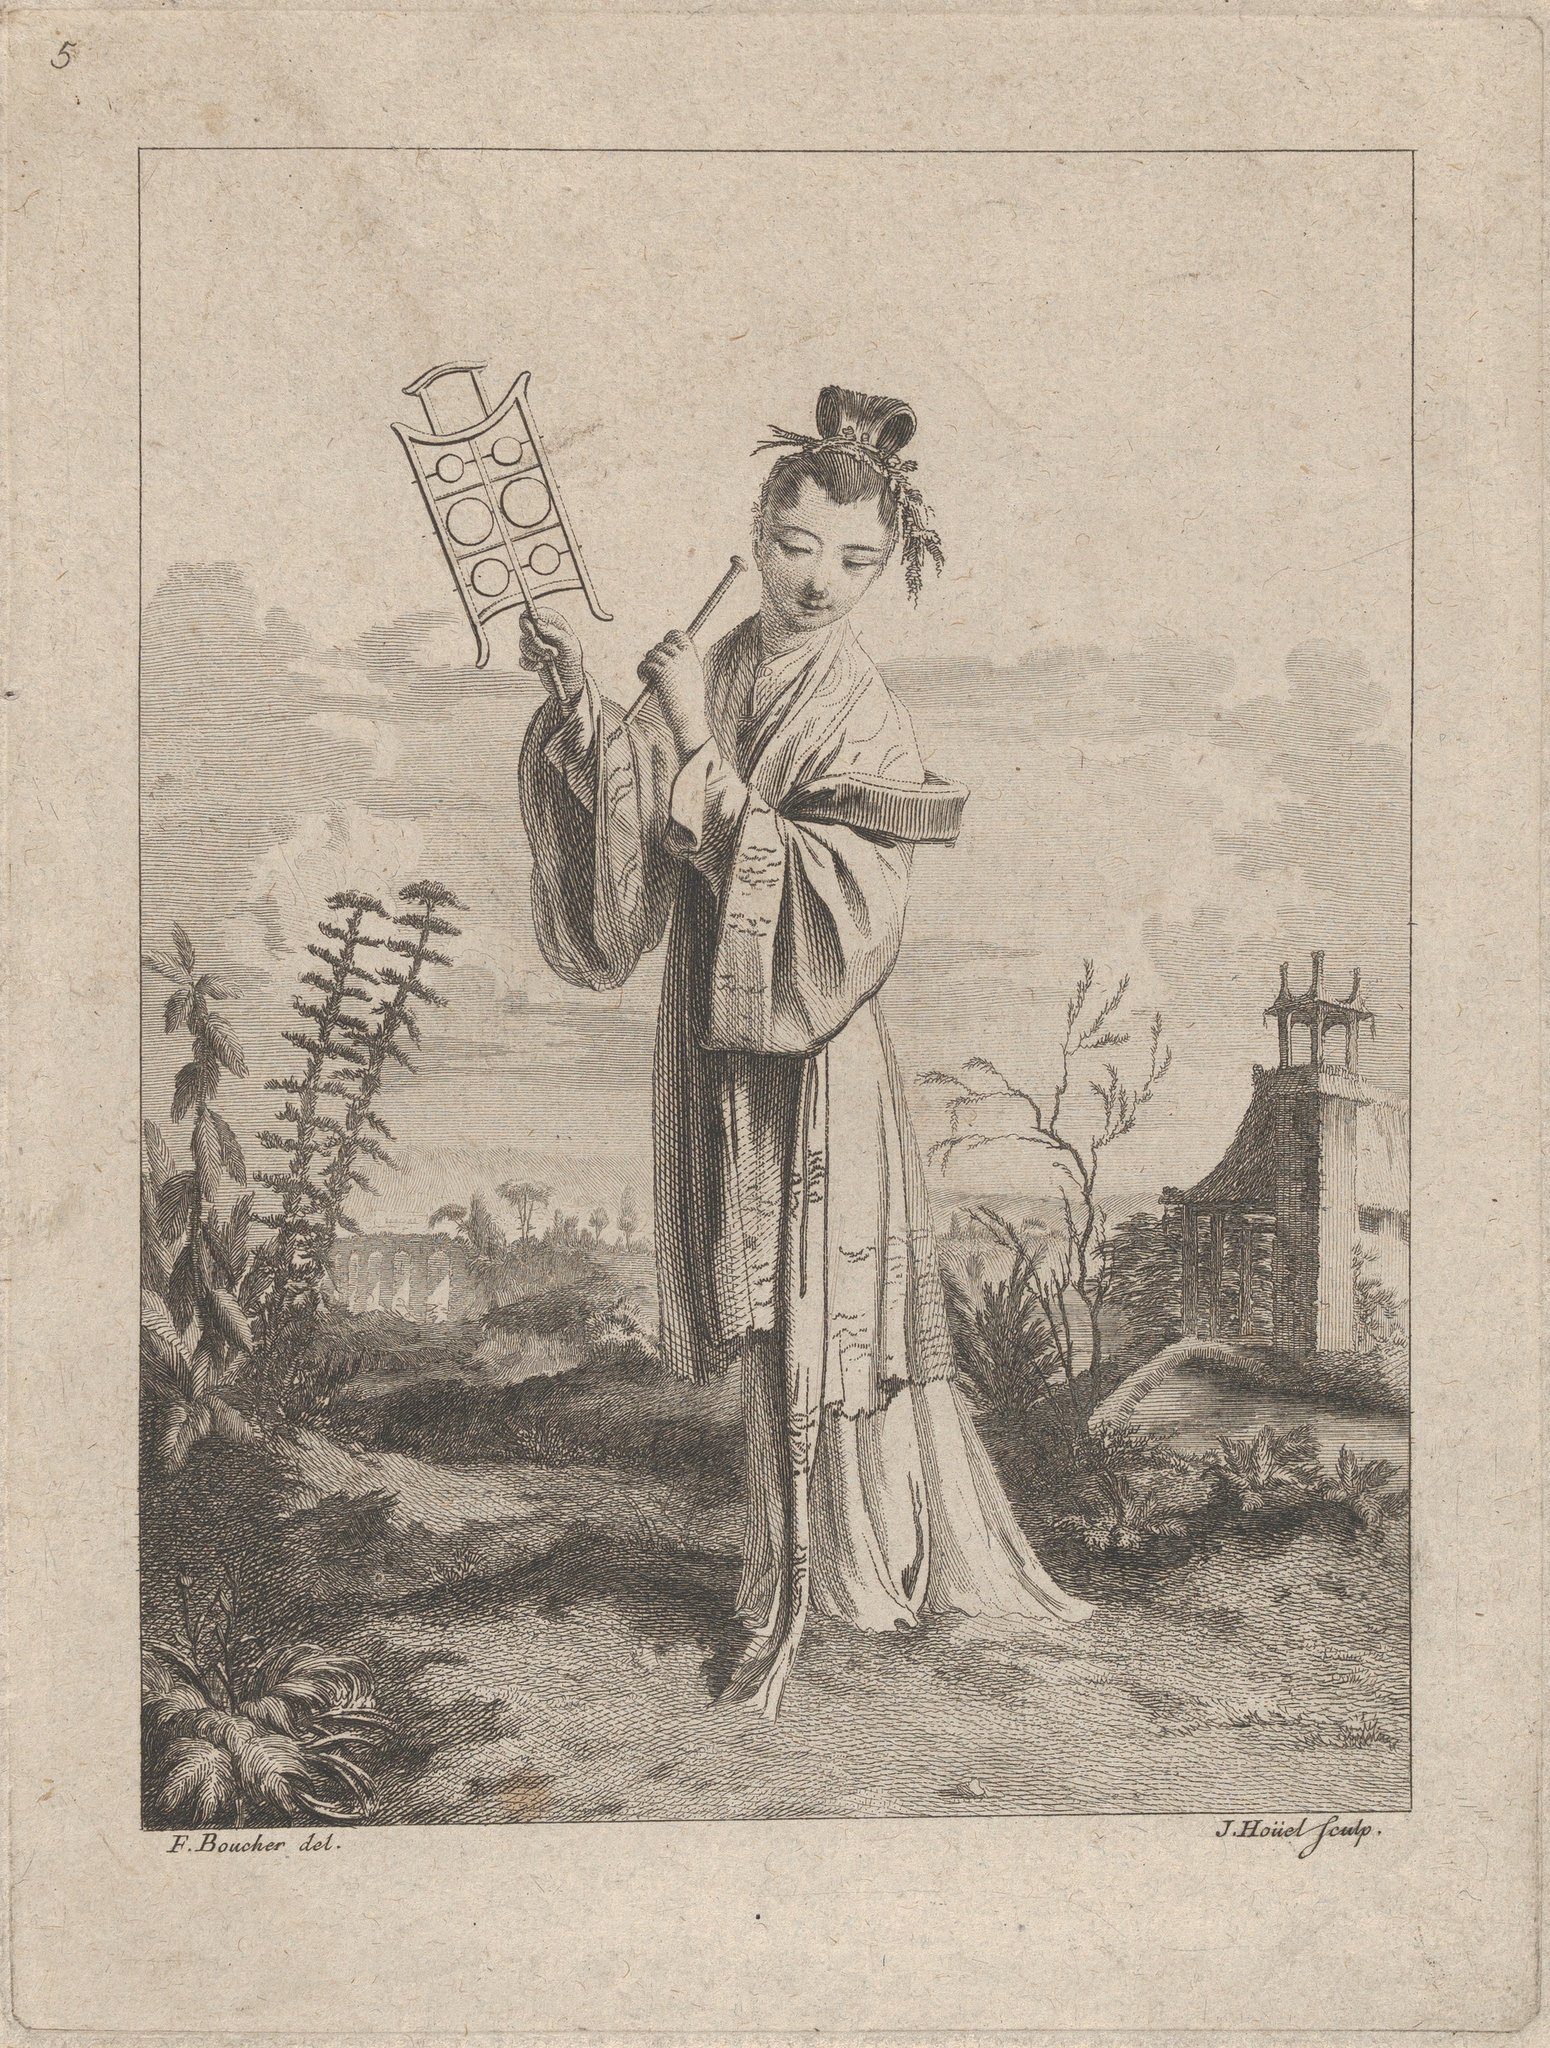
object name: print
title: Chinoiserie with a woman playing a musical instrument, from Suite de Figures Chinoises. . .Tiré du Cabinet de Mr. d'Azaincourt (Series of Chinoiserie Figures. . .From the Chambers of Mr. d'Azaincourt), plate 5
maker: jean pierre louis laurent hoüel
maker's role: artist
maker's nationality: french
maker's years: 1735-1813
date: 1755-1776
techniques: engraving, etching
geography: france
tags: musical instruments,chinoiserie,women